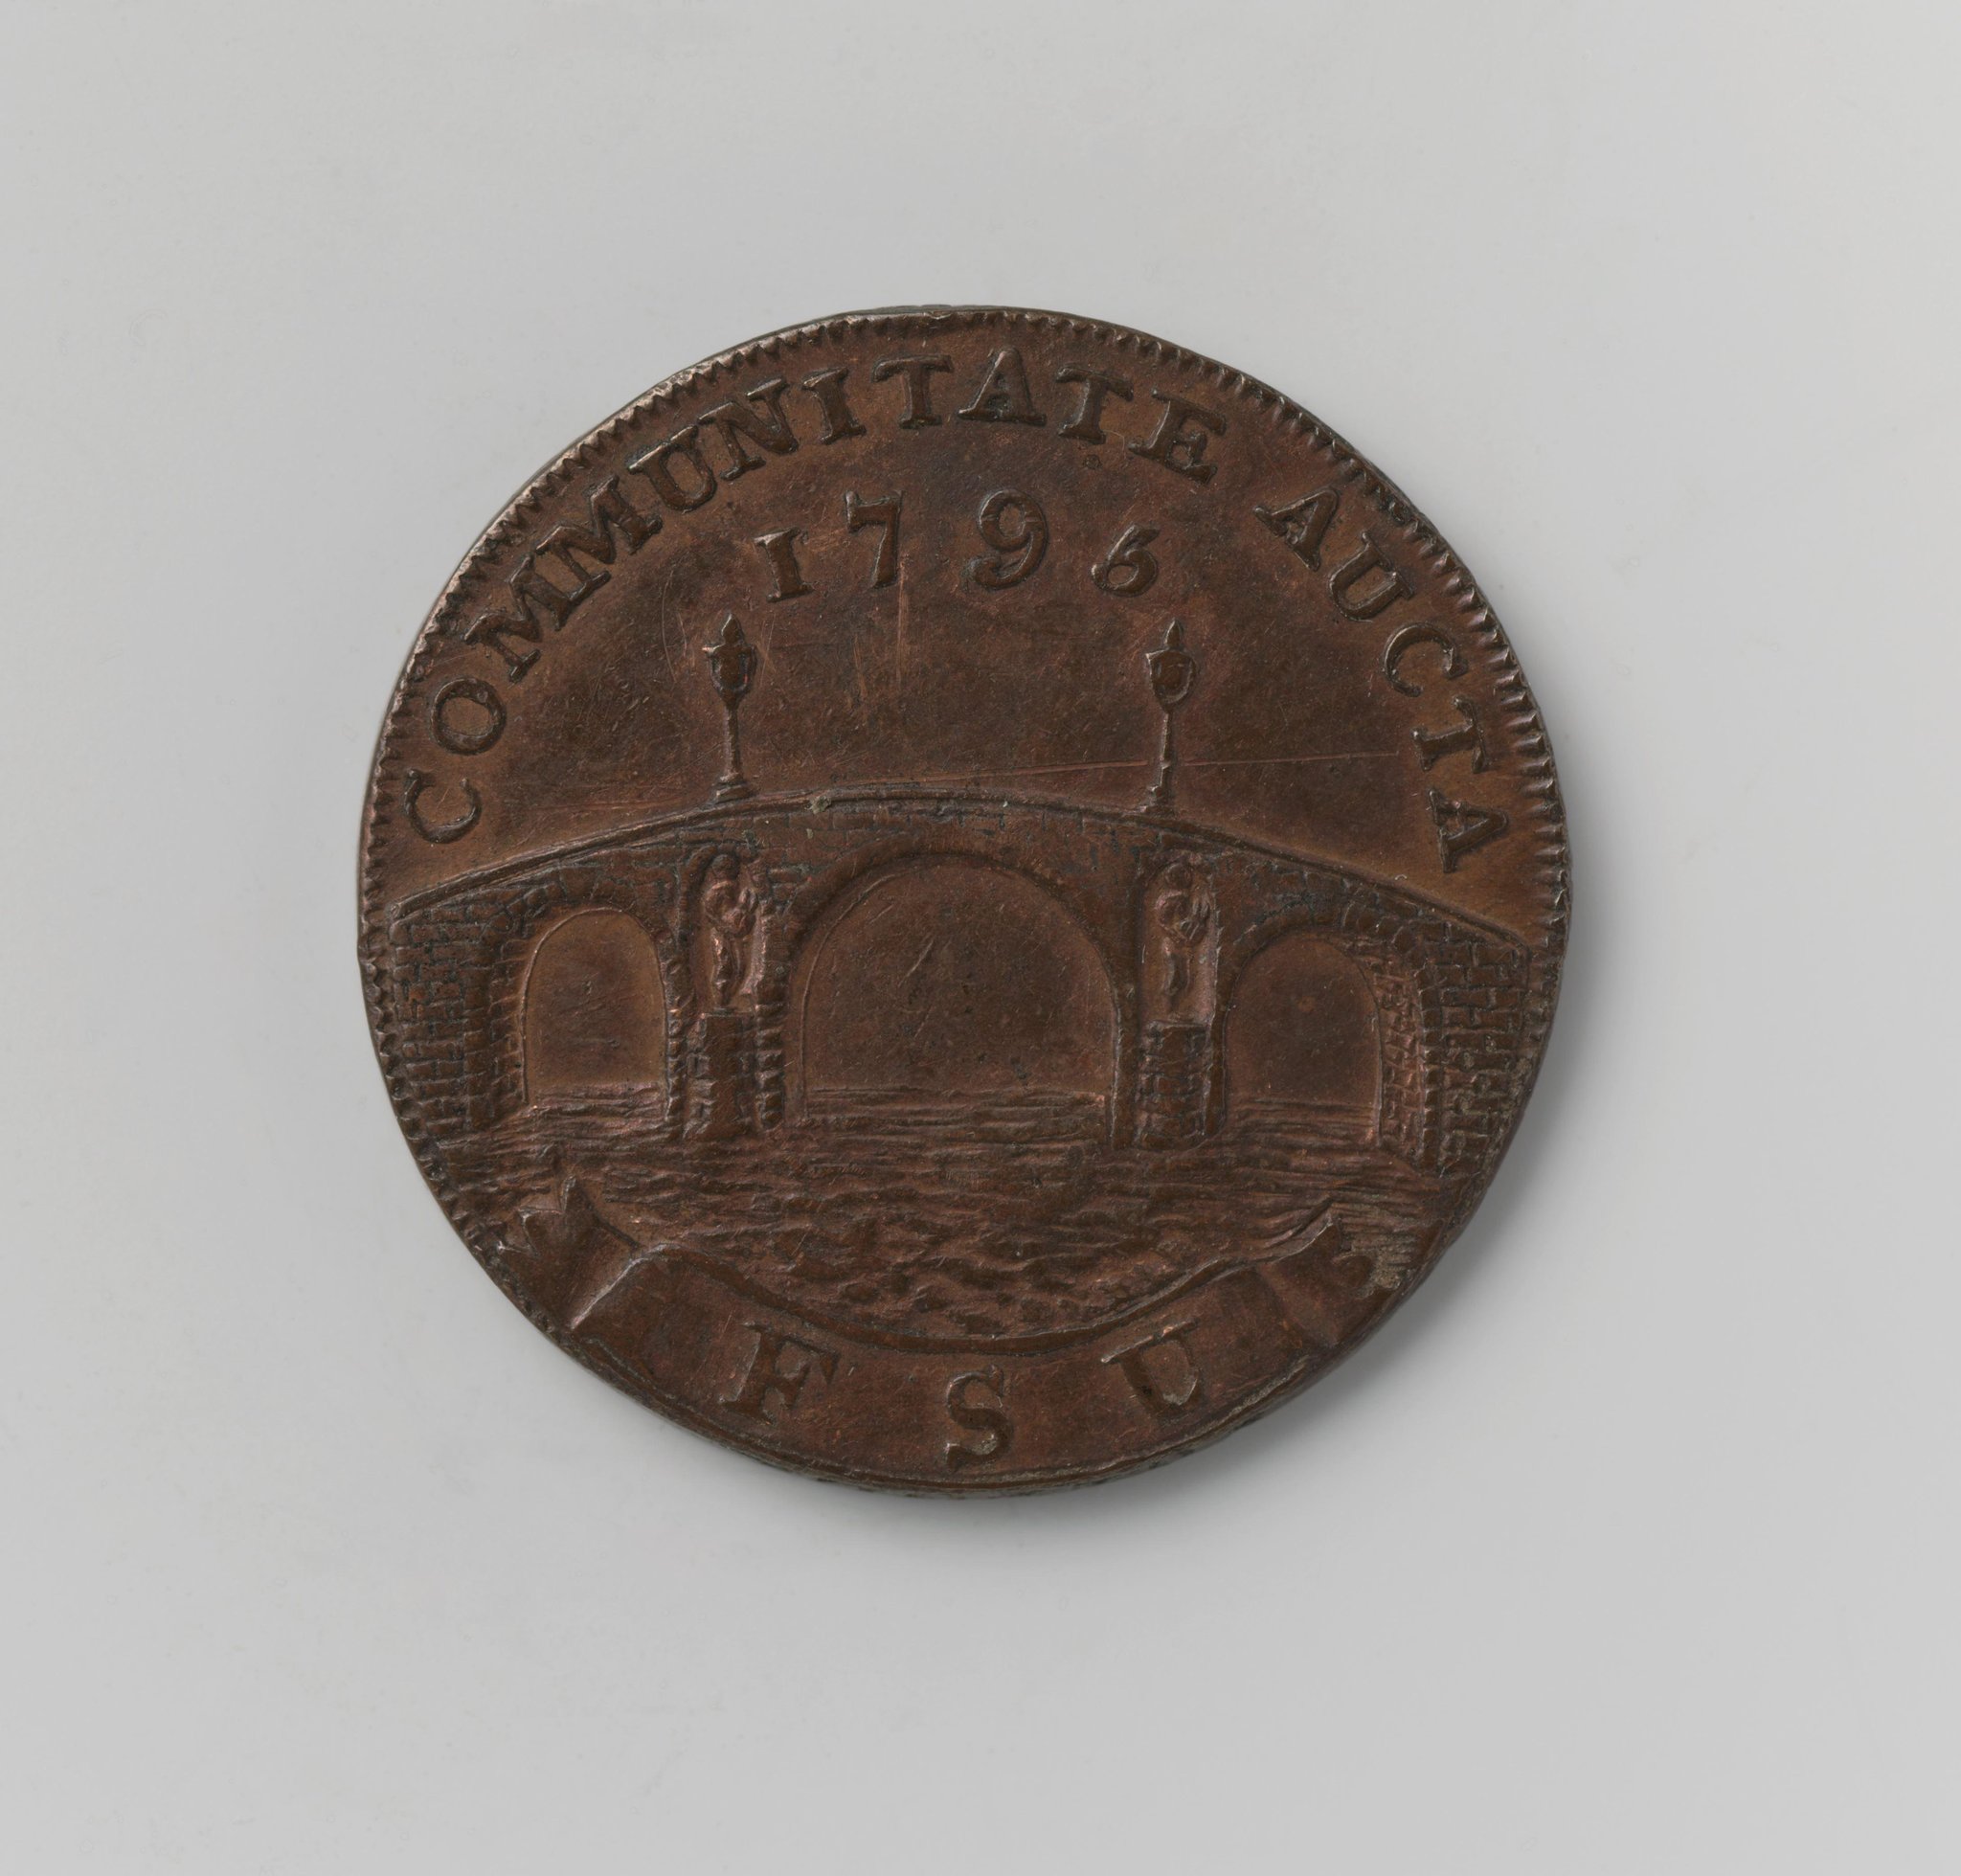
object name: penny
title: Token voor een penny uit Beccles, Engeland, 1795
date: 1795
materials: copper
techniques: striking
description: Koperen particuliere munt. Voorzijde: gebouw. Keerzijde: brug met jaartal in veld. Randschrift.